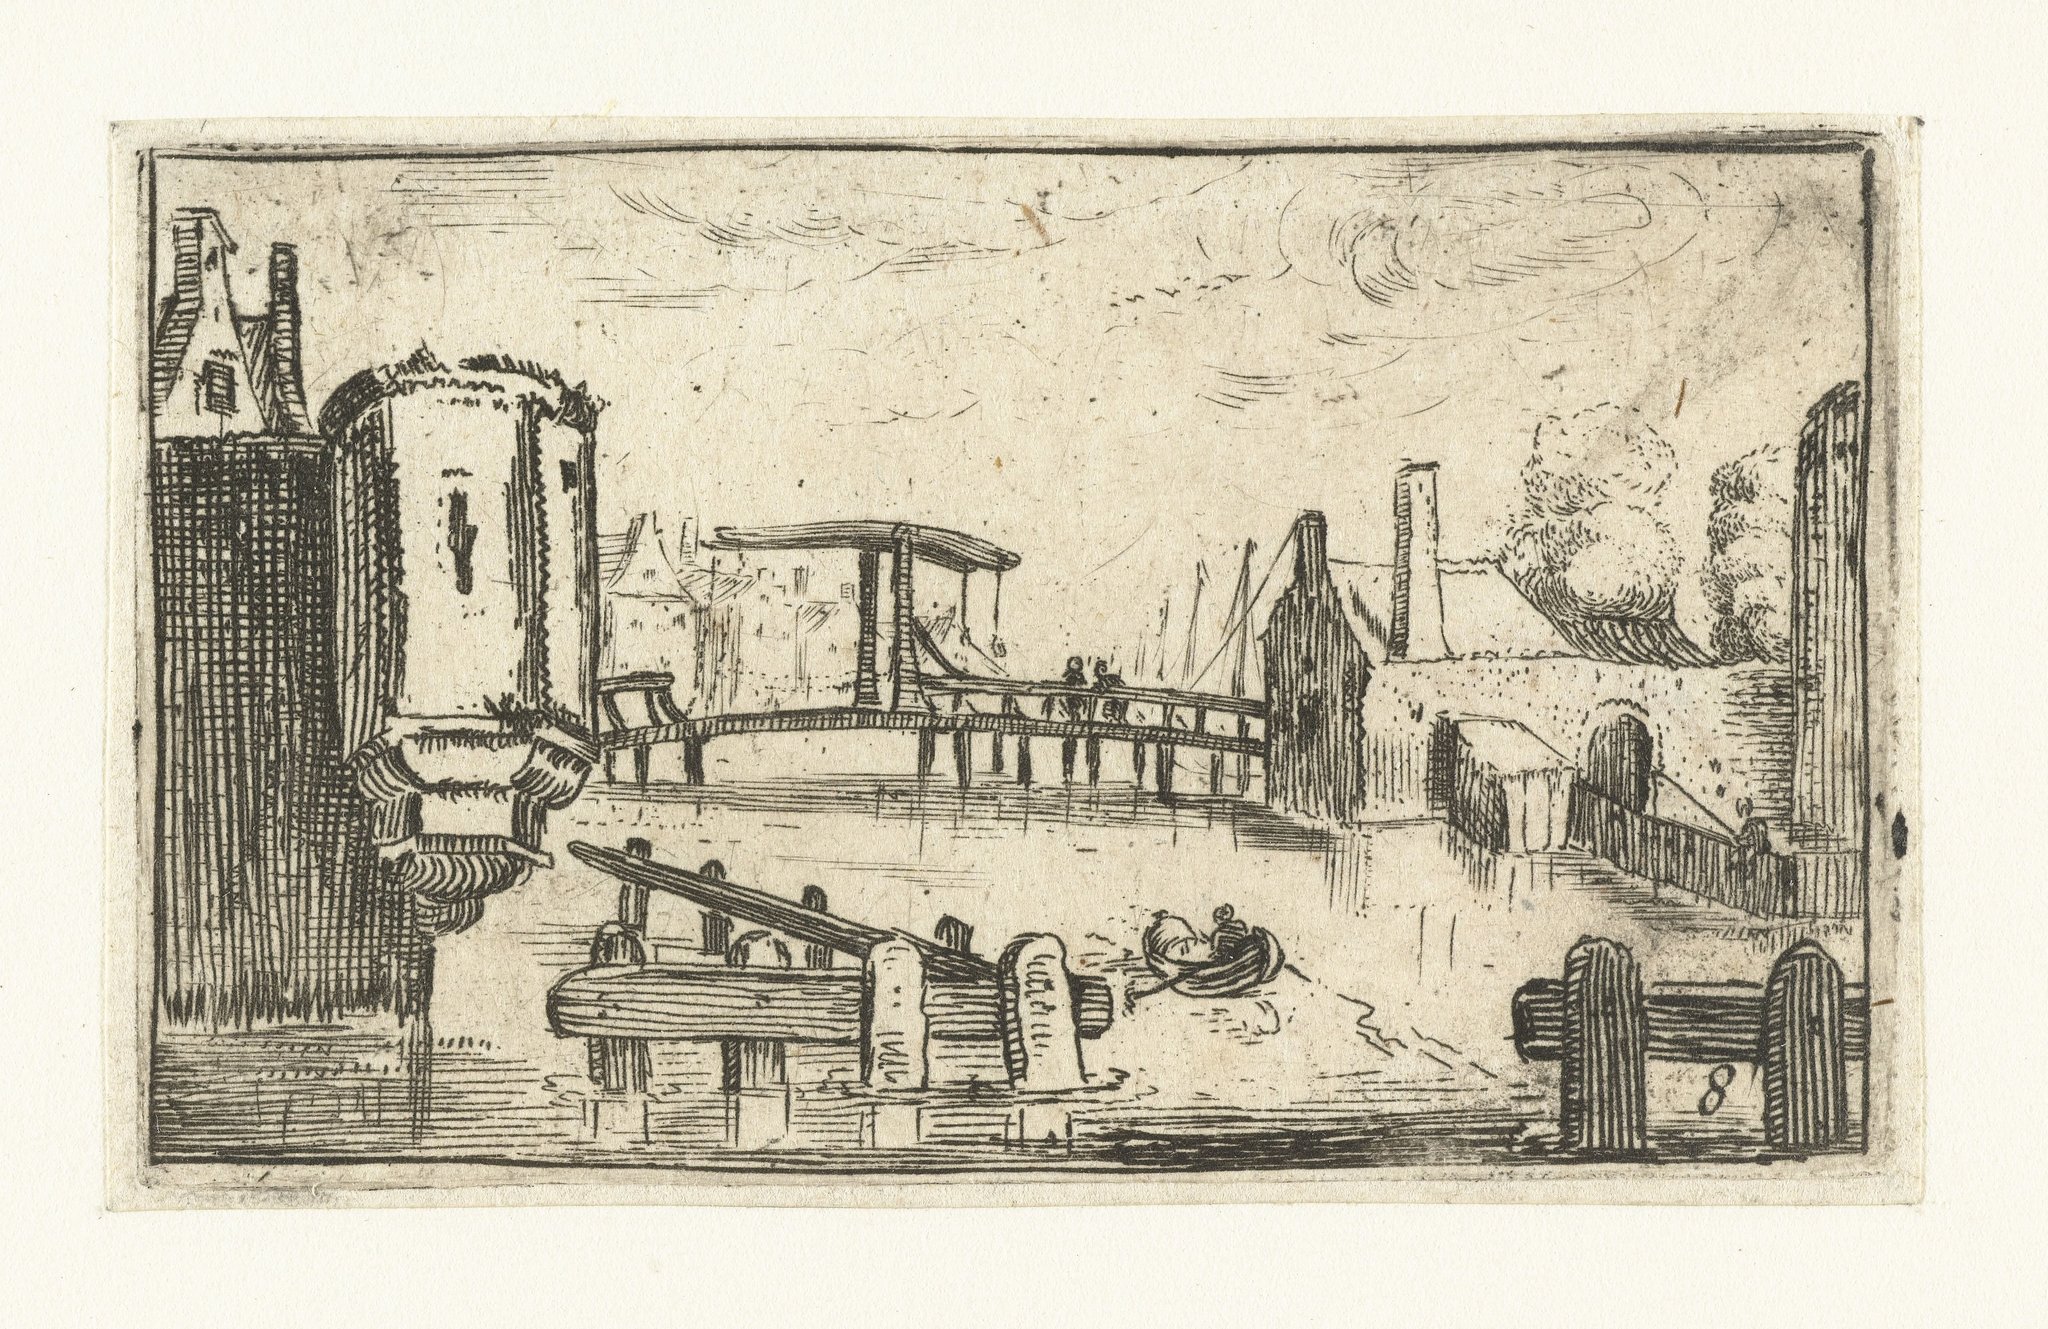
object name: print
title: Gracht met ophaalbrug in een stad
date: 1613-1617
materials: paper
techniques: engraving, etching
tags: canals, waters (in city)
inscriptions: collector's mark: Lugt 240